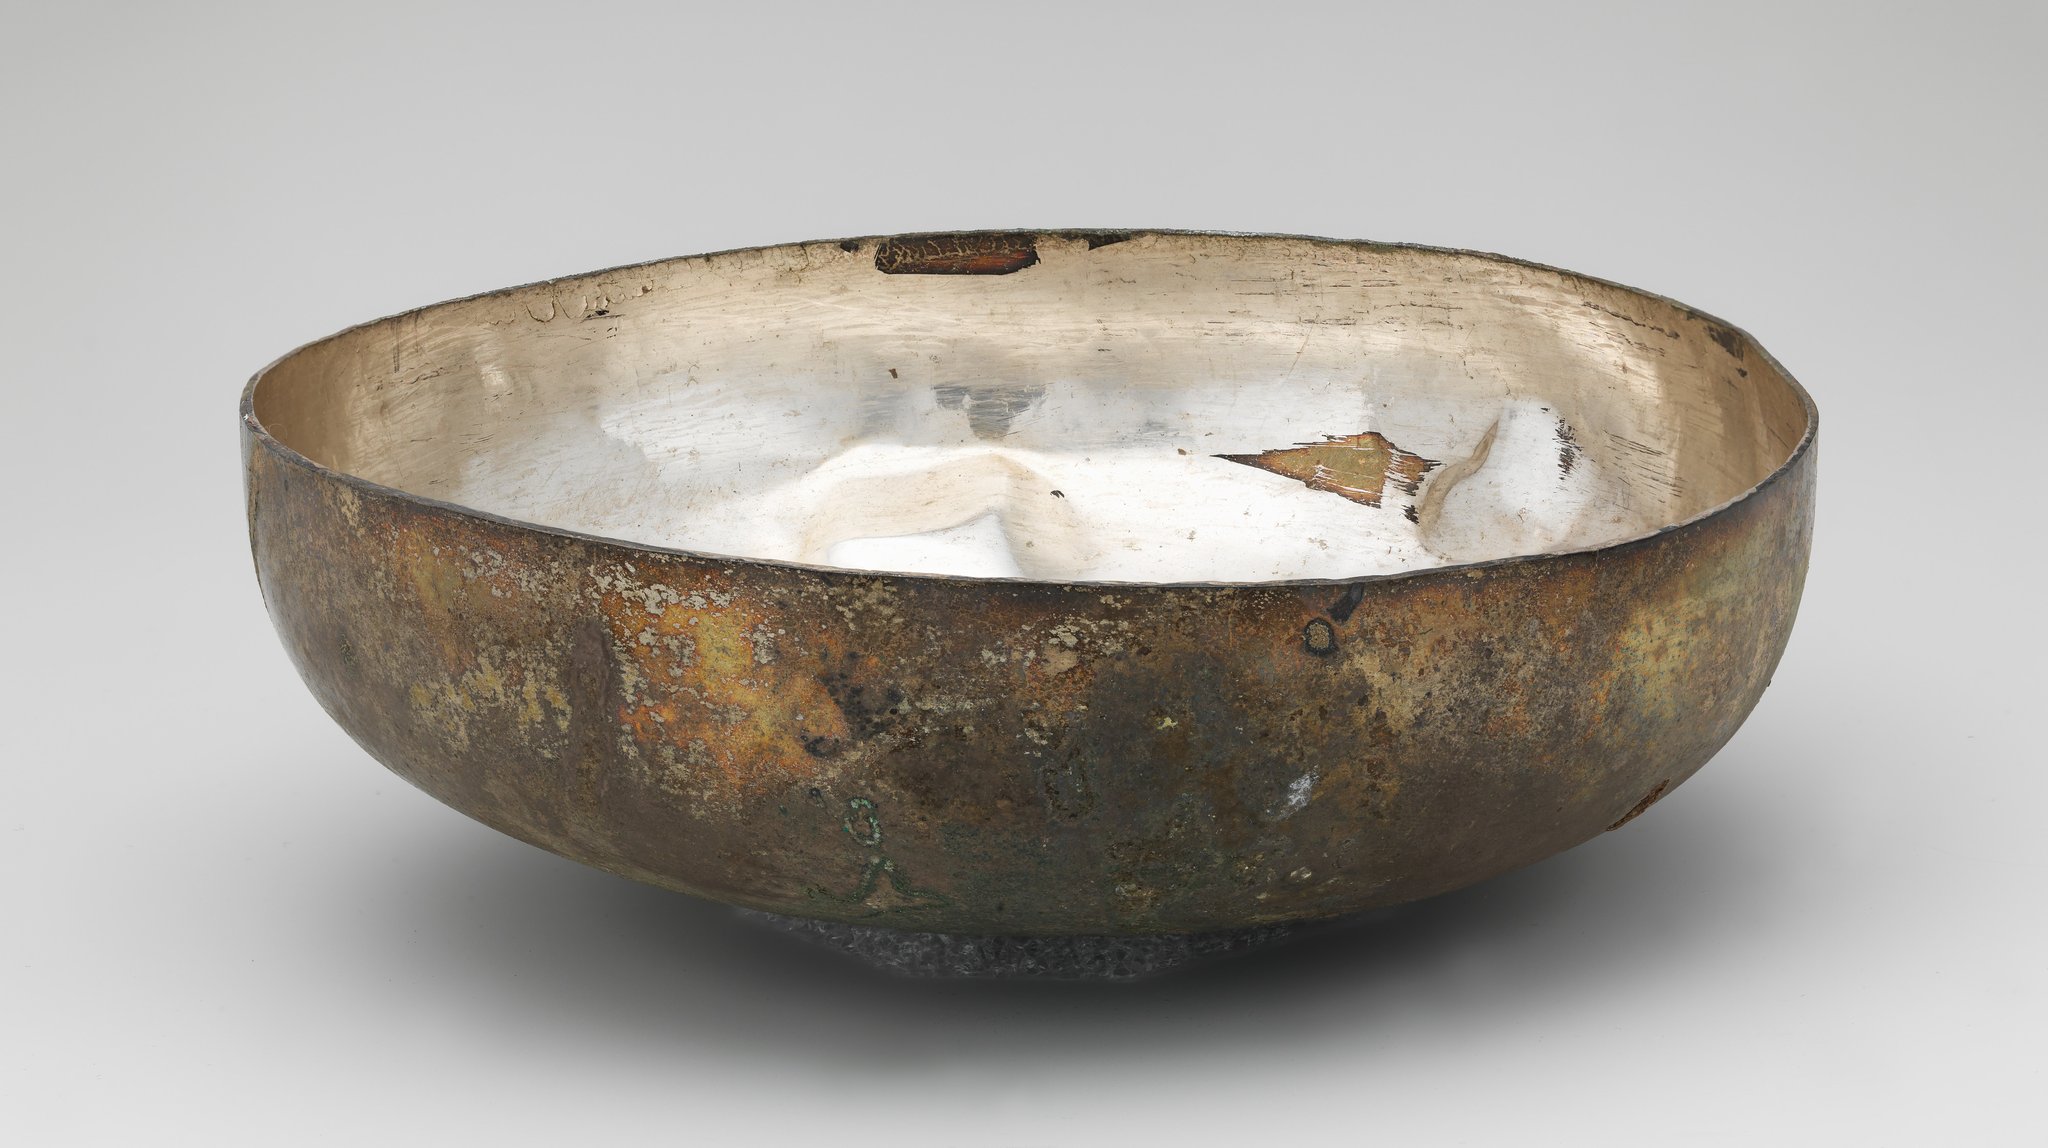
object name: bowl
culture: chimú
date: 1101-1500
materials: silver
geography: peru